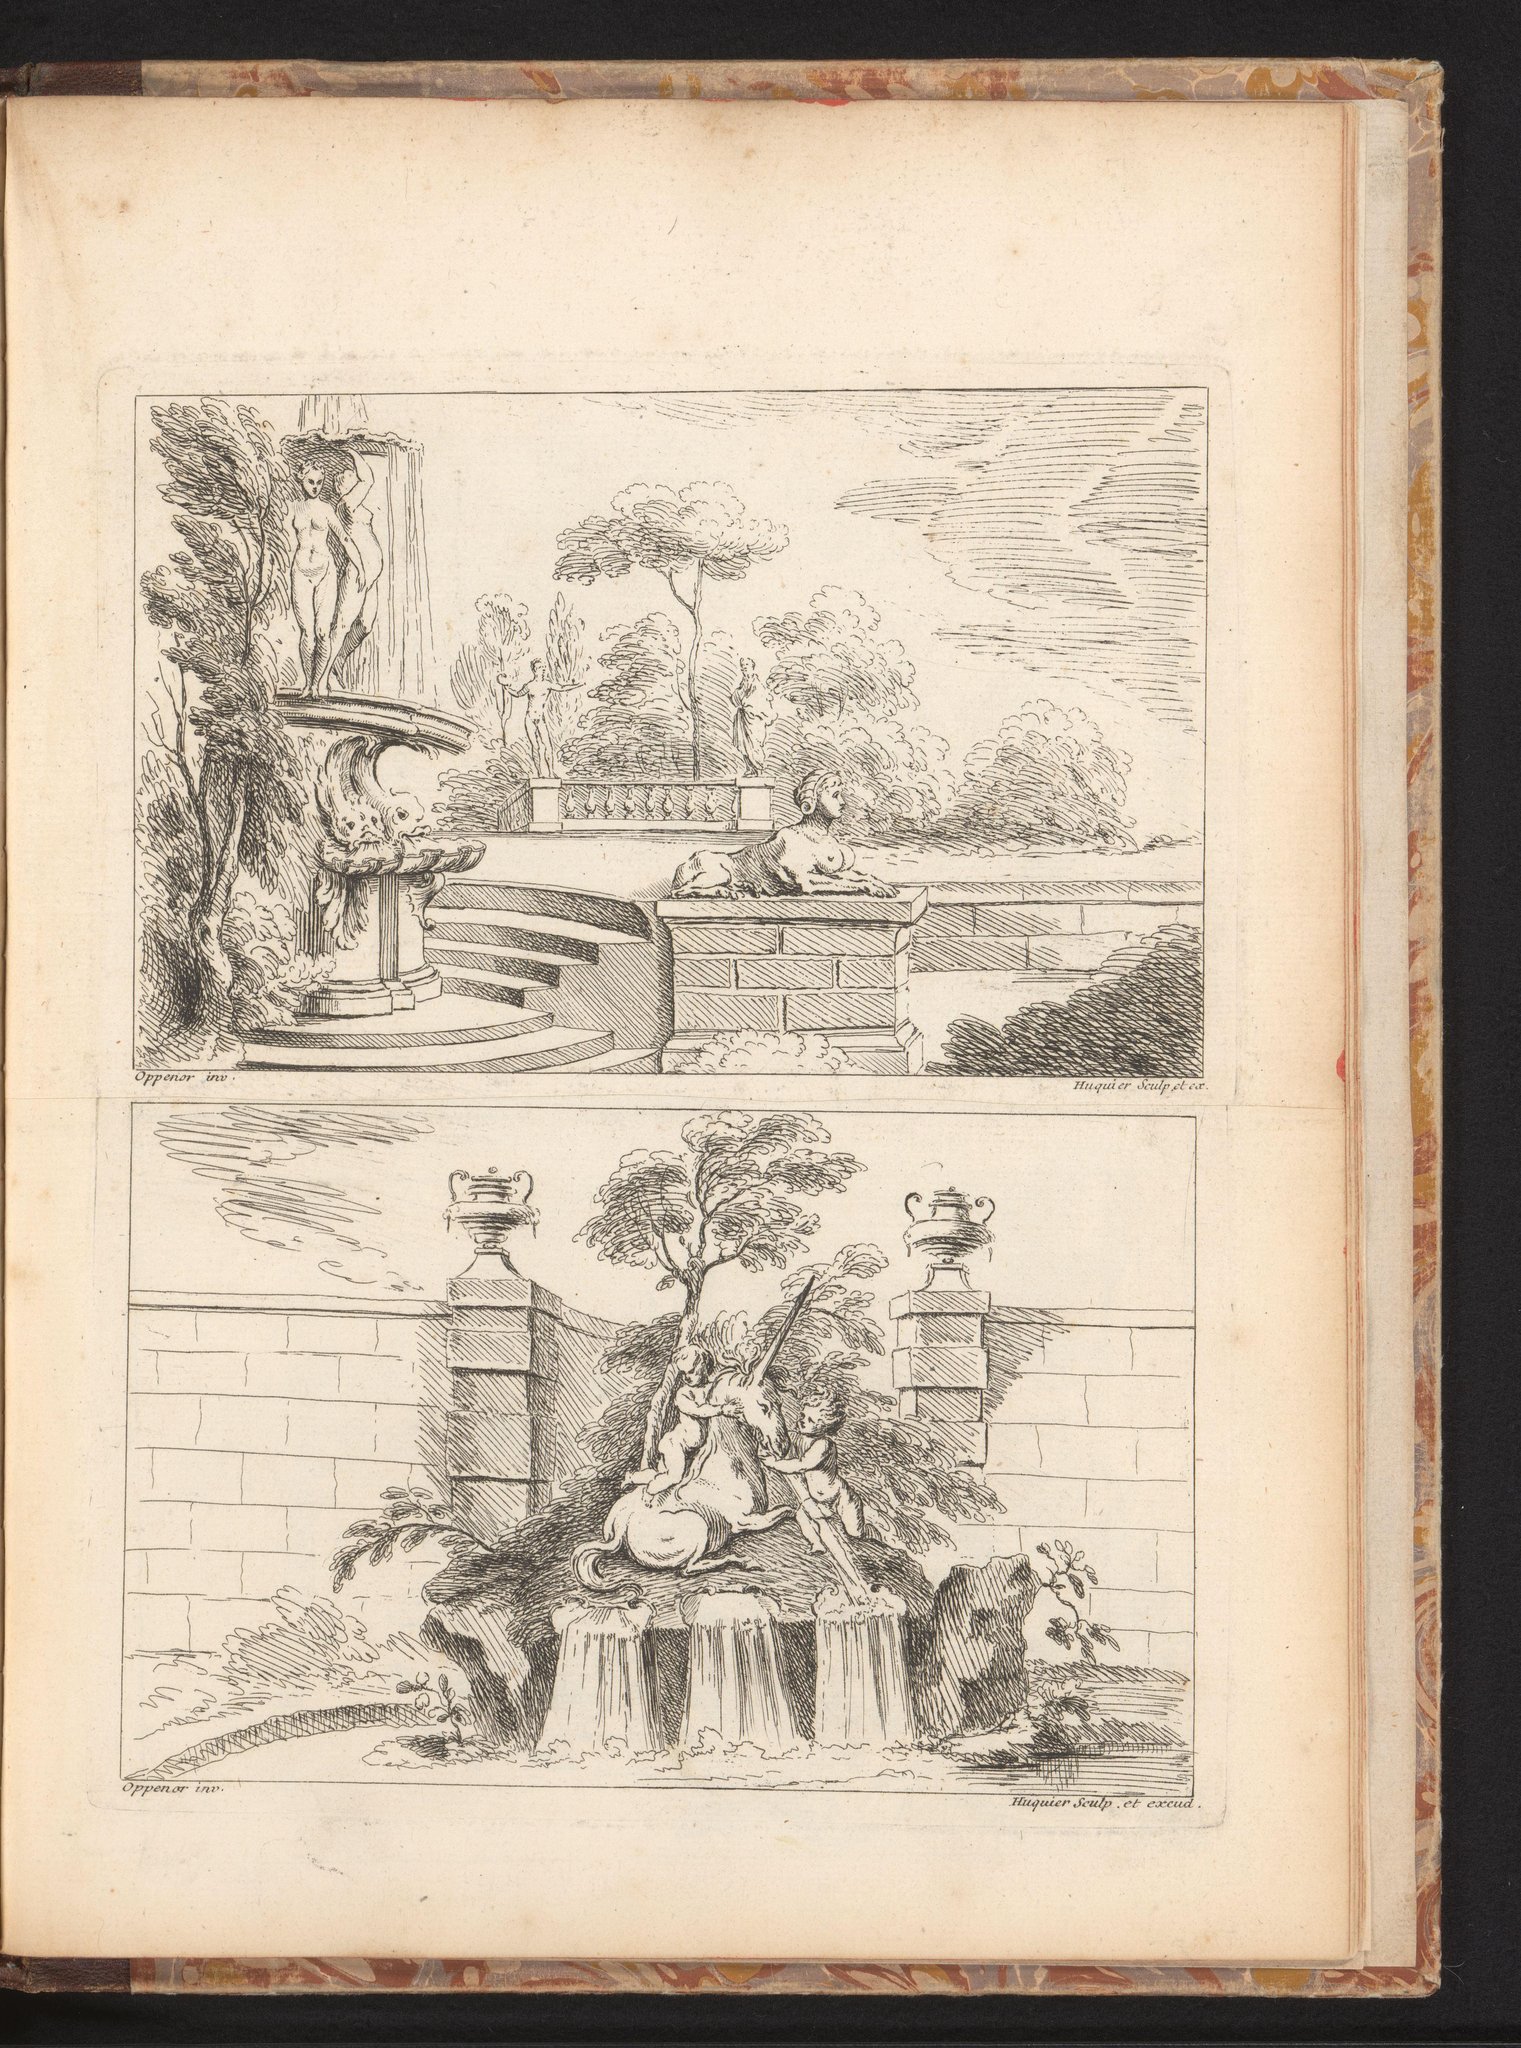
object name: album leaf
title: Nouveau livre de fontaines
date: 1725-1750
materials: paper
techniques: etching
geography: paris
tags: unicorn, garden fountain, ornamental fountain, cupids: 'amores', 'amoretti', 'putti'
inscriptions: collector's mark: Lugt 2228a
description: De prenten van deze reeks zijn telkens per twee aan elkaar geplakt om in het boek mee te binden met hetzelfde formaat als de voorgaande bladen.